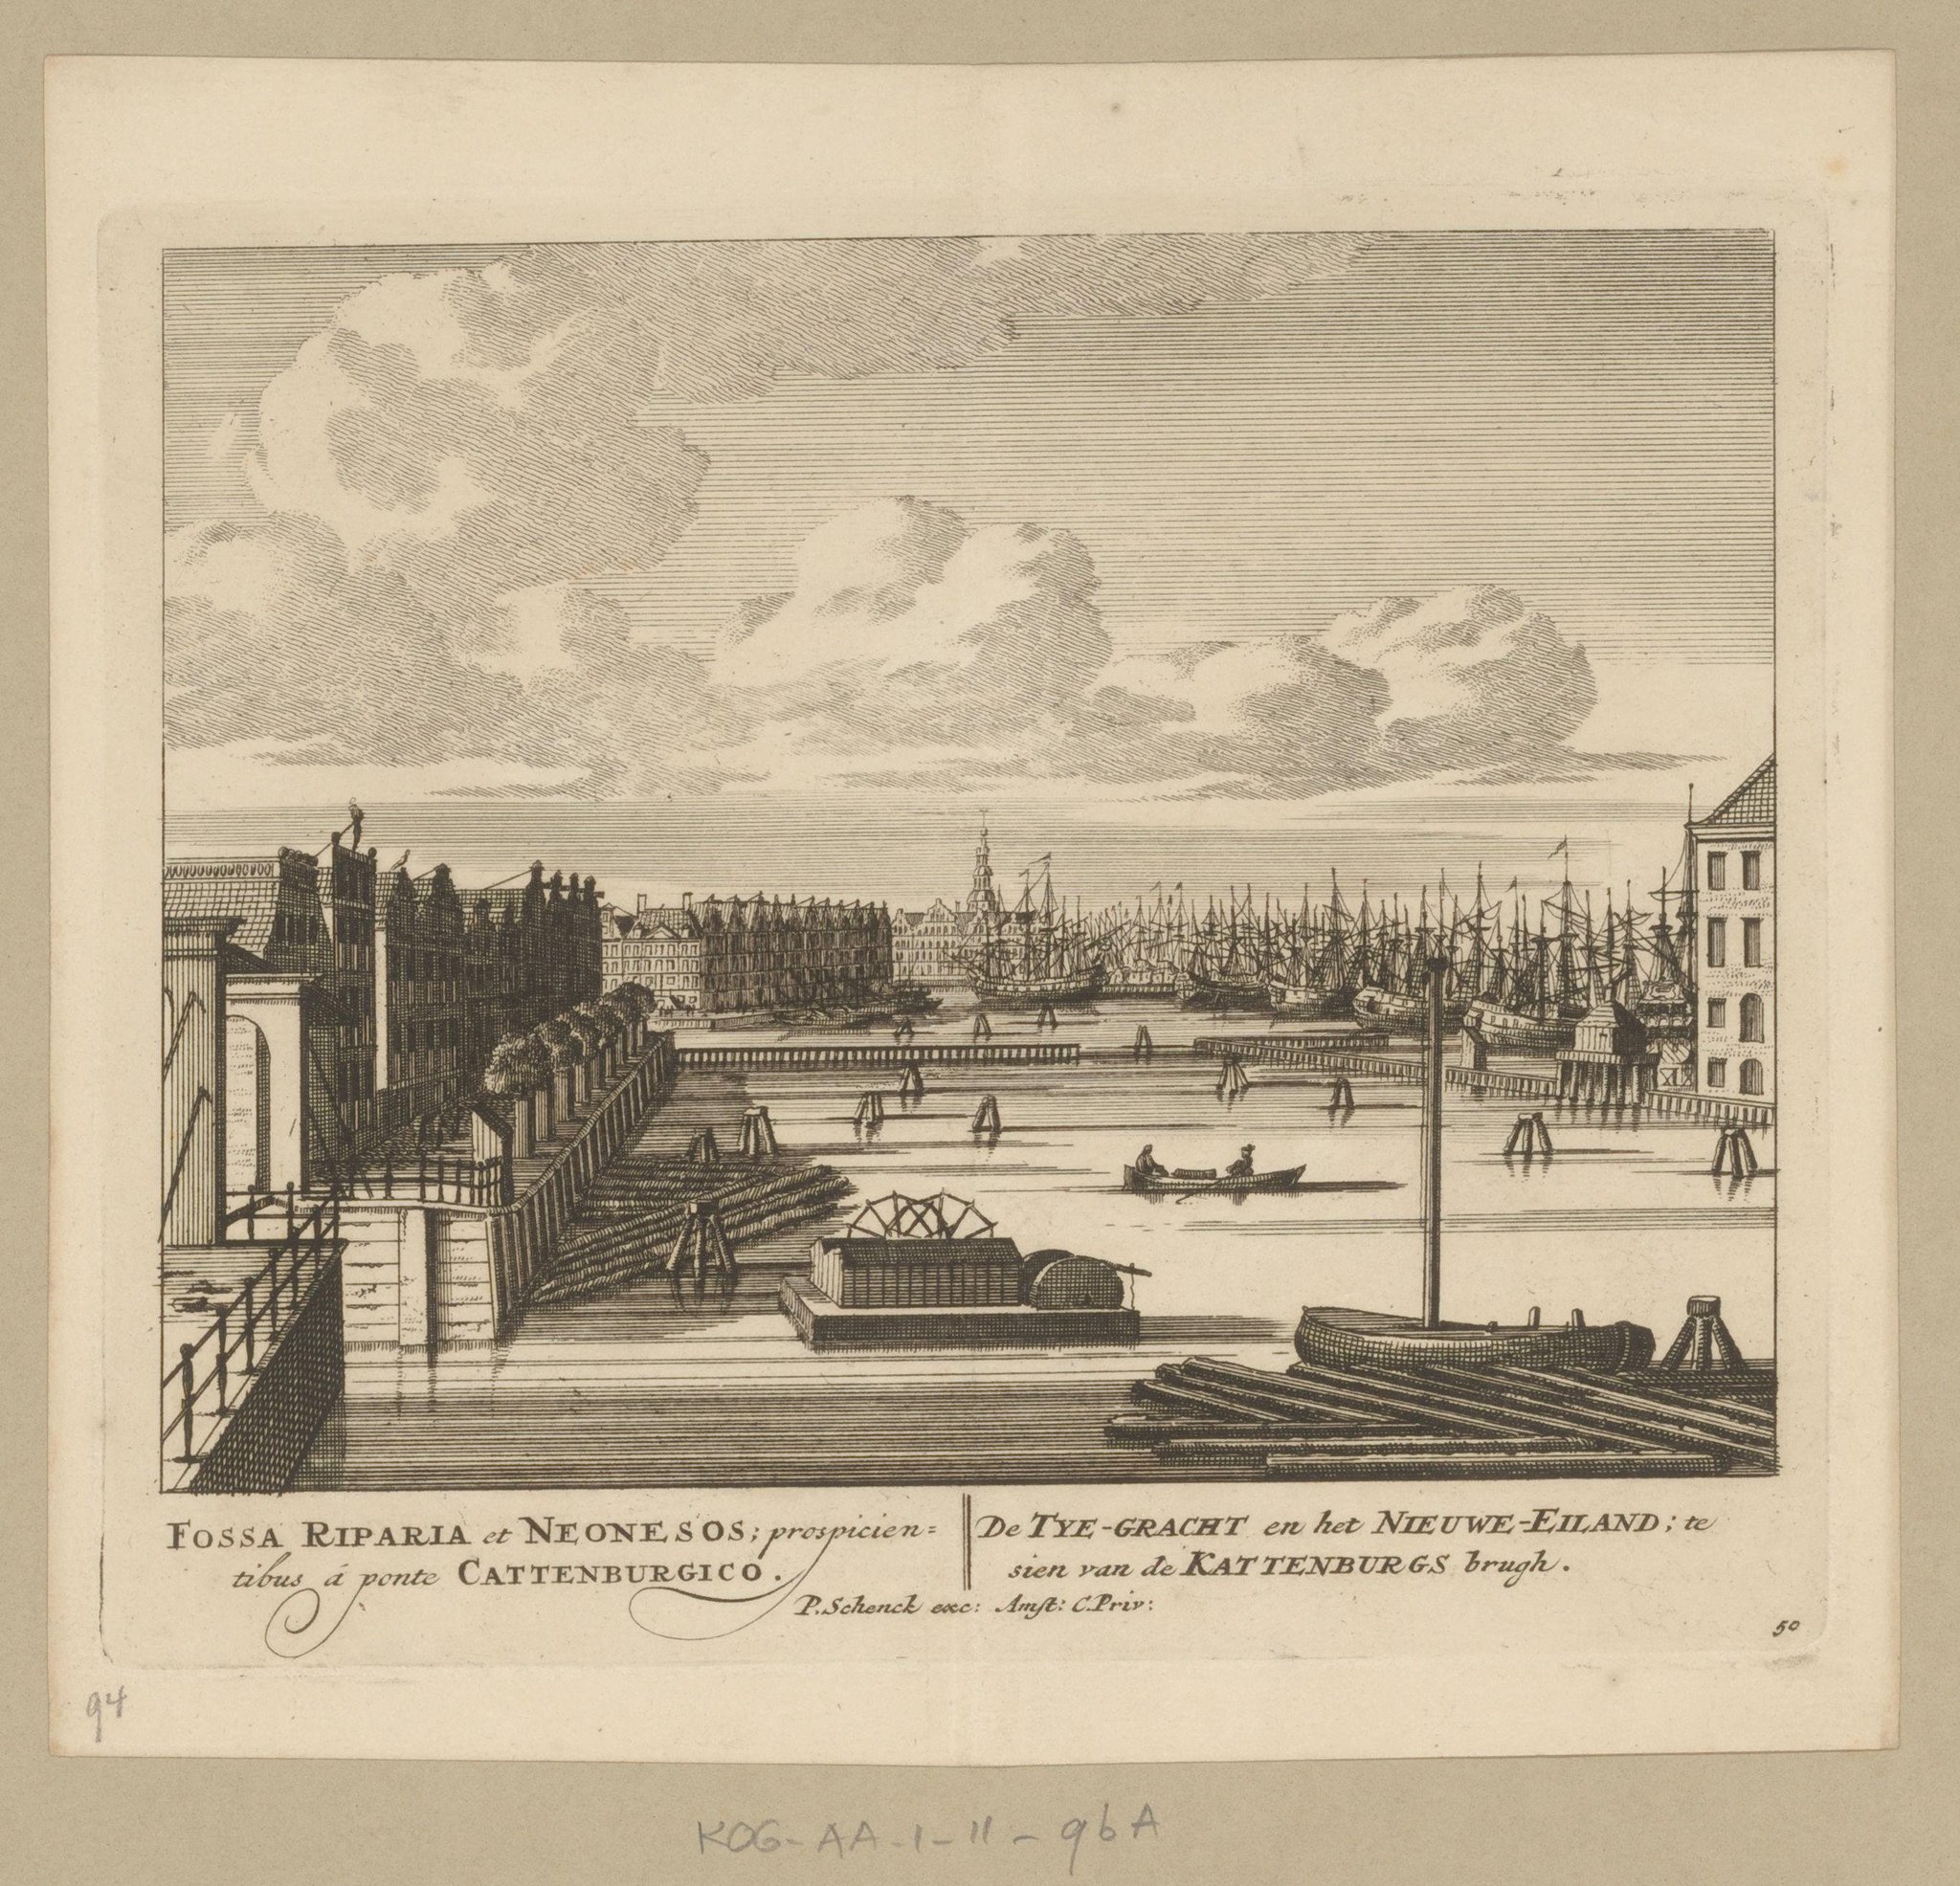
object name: print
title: Fossa Riparia et Neonesos; prospicien:tibus a ponte Cattenburgico / De Tye-Gracht en het Nieuwe-Eiland: te sien van de Kattenburgs brugh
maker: Anonymous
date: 1710-1711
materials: paper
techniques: etching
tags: sailing-ship, sailing-boat, city-view in general; 'veduta', river, bridge in city across river, canal, etc., street, boat propelled by man or animal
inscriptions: collector's mark: ‘11.96AB’ Lugt 1641b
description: Huidige staat van prent ook gebruikt in: 100 Afbeeldinge der voornaamste gebouwen van Amsterdam. Amsterdam, Pieter Schenk (I), s.a. [1710-1711]. En in: 100 Afbeeldinge der voornaamste gebouwen van Amsterdam. Amsterdam, Barent Greve, s.a. [1757-1766].* *In de tweede uitgave, uitgegeven door Barent Greve, is alleen de titelprent aangepast. De overige prenten zijn onveranderd gebleven.